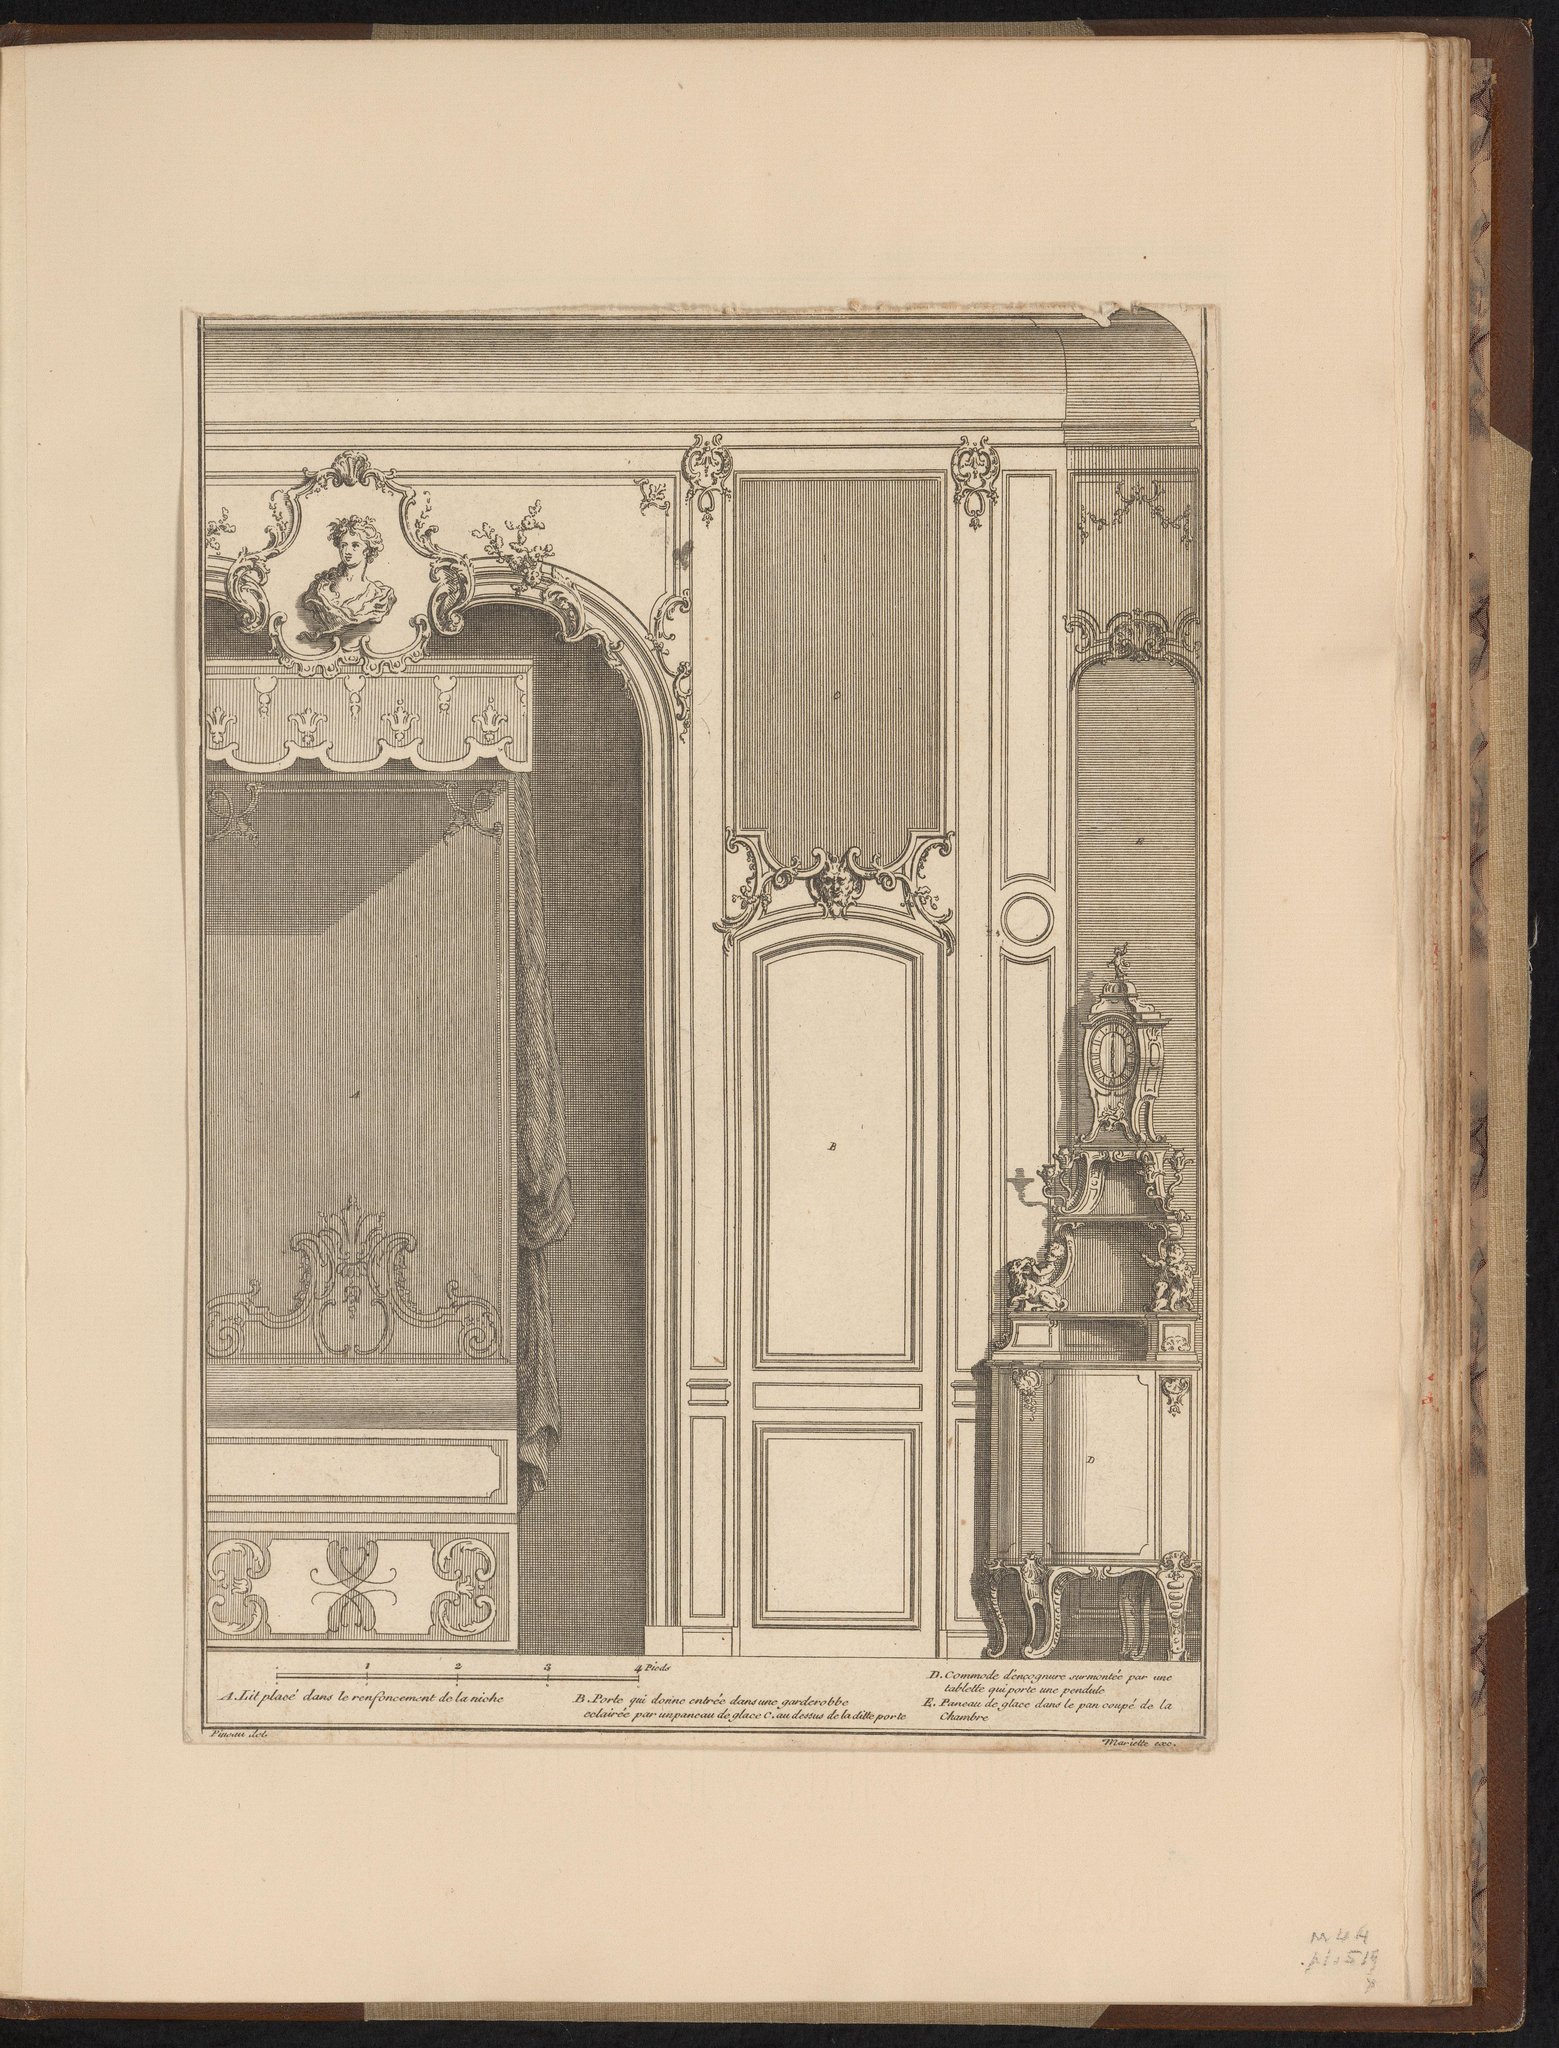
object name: album leaf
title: Ontwerp voor een interieur van een slaapkamer met kast en bed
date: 1725-1750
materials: paper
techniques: etching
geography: paris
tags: ornaments ~ art, panelling, bed, bedroom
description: Deze prent maakt deel uit van een album.